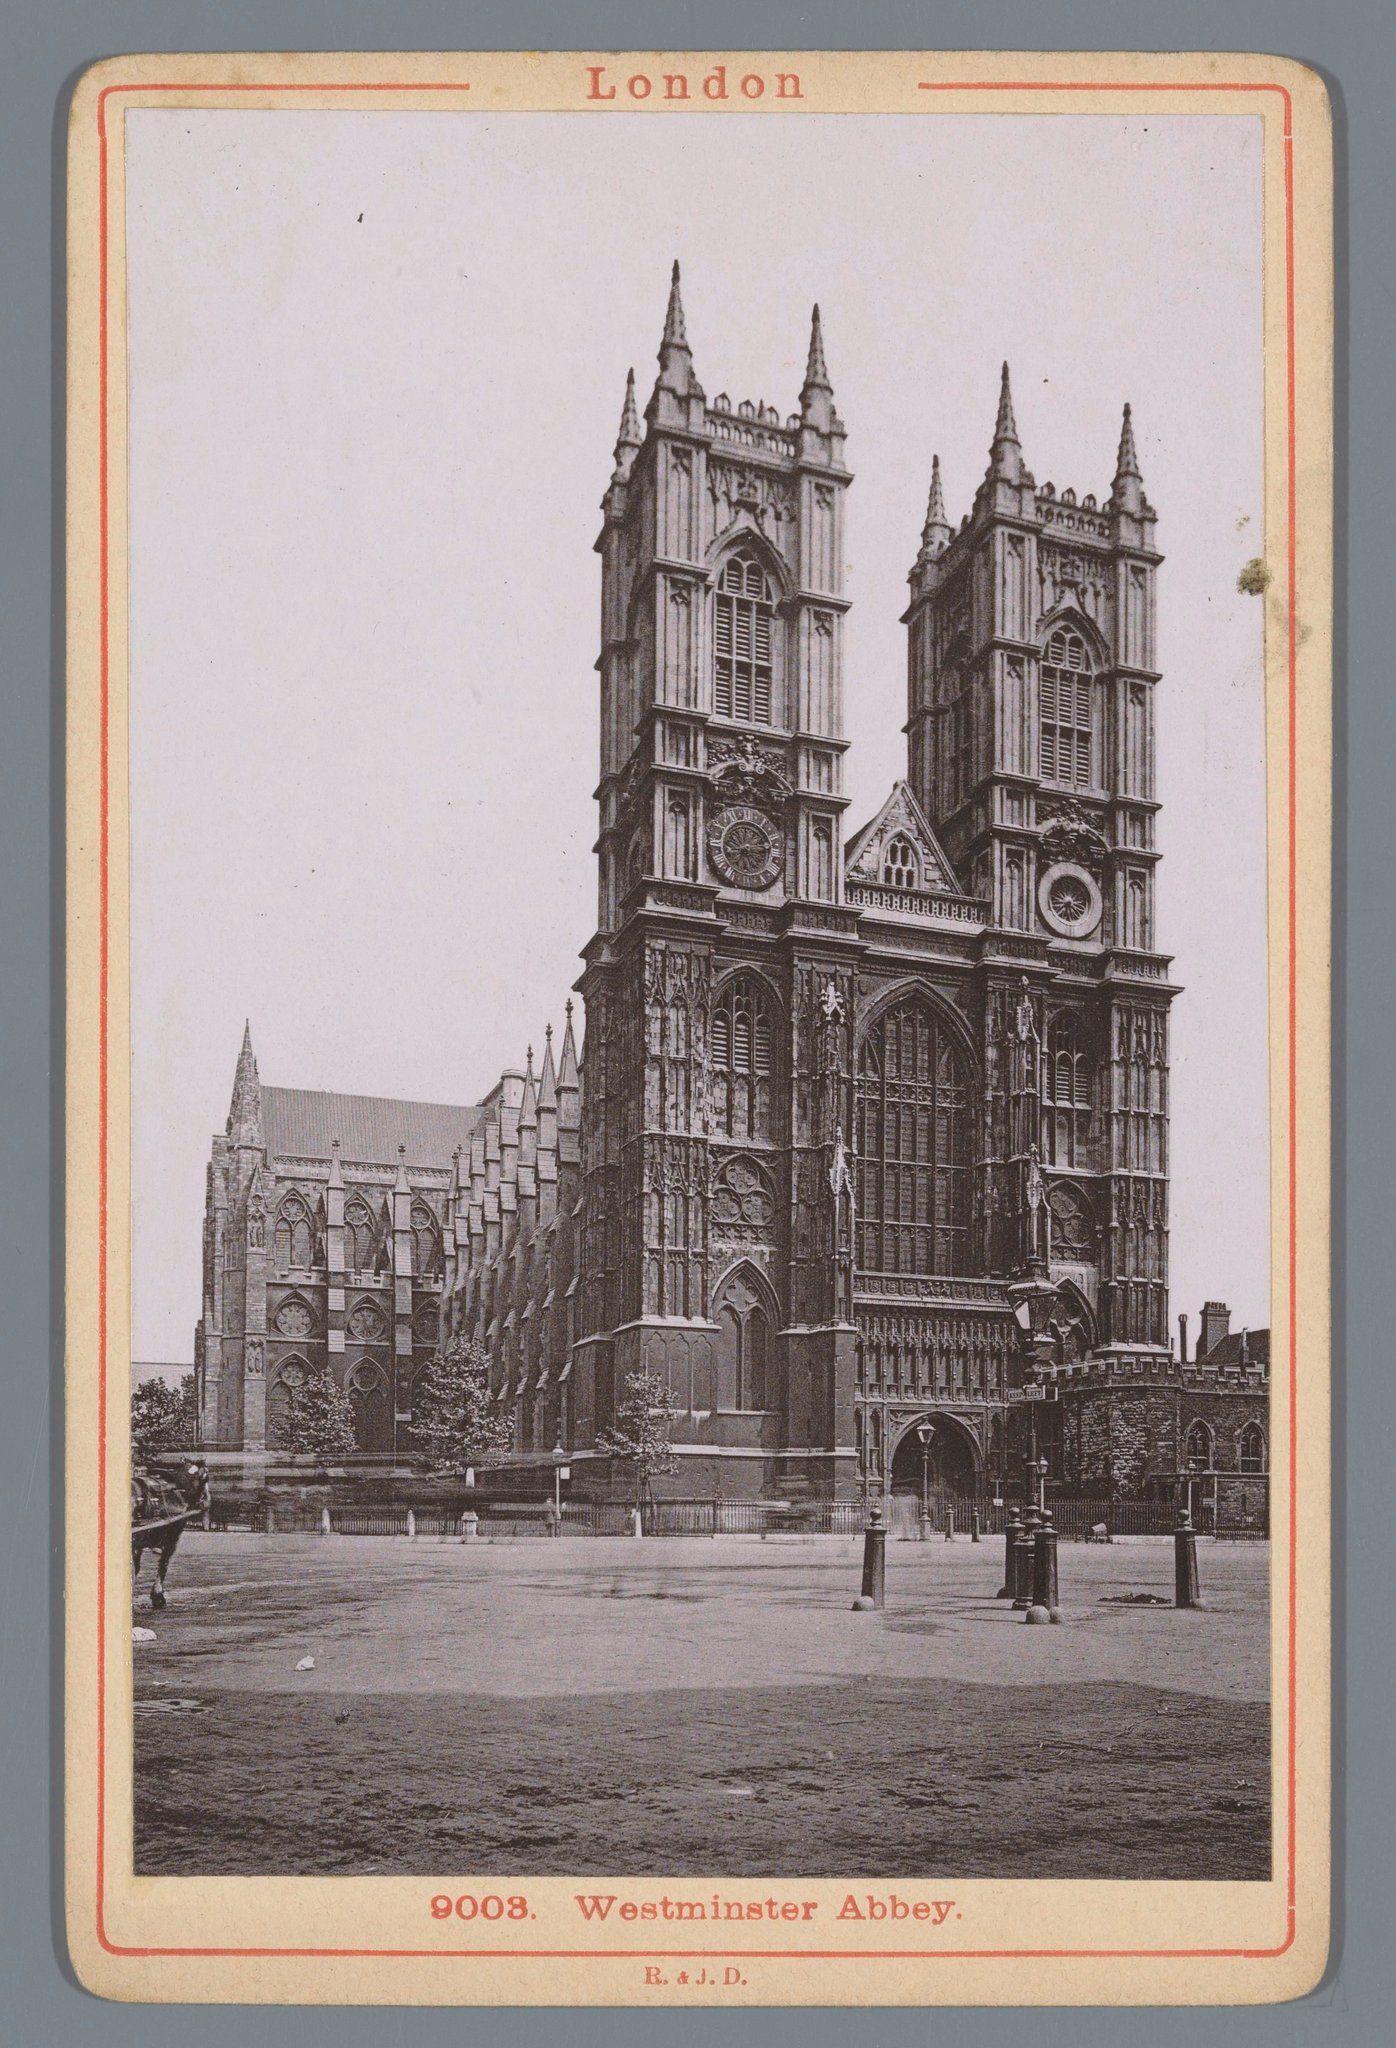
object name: photomechanical print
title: Gezicht op Westminster Abbey in Londen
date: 1880-1900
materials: cardboard, paper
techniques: photograph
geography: westminster abbey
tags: church (exterior), westminster abbey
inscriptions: number: ‘9003.’, date: ‘24 Septembre 1894’